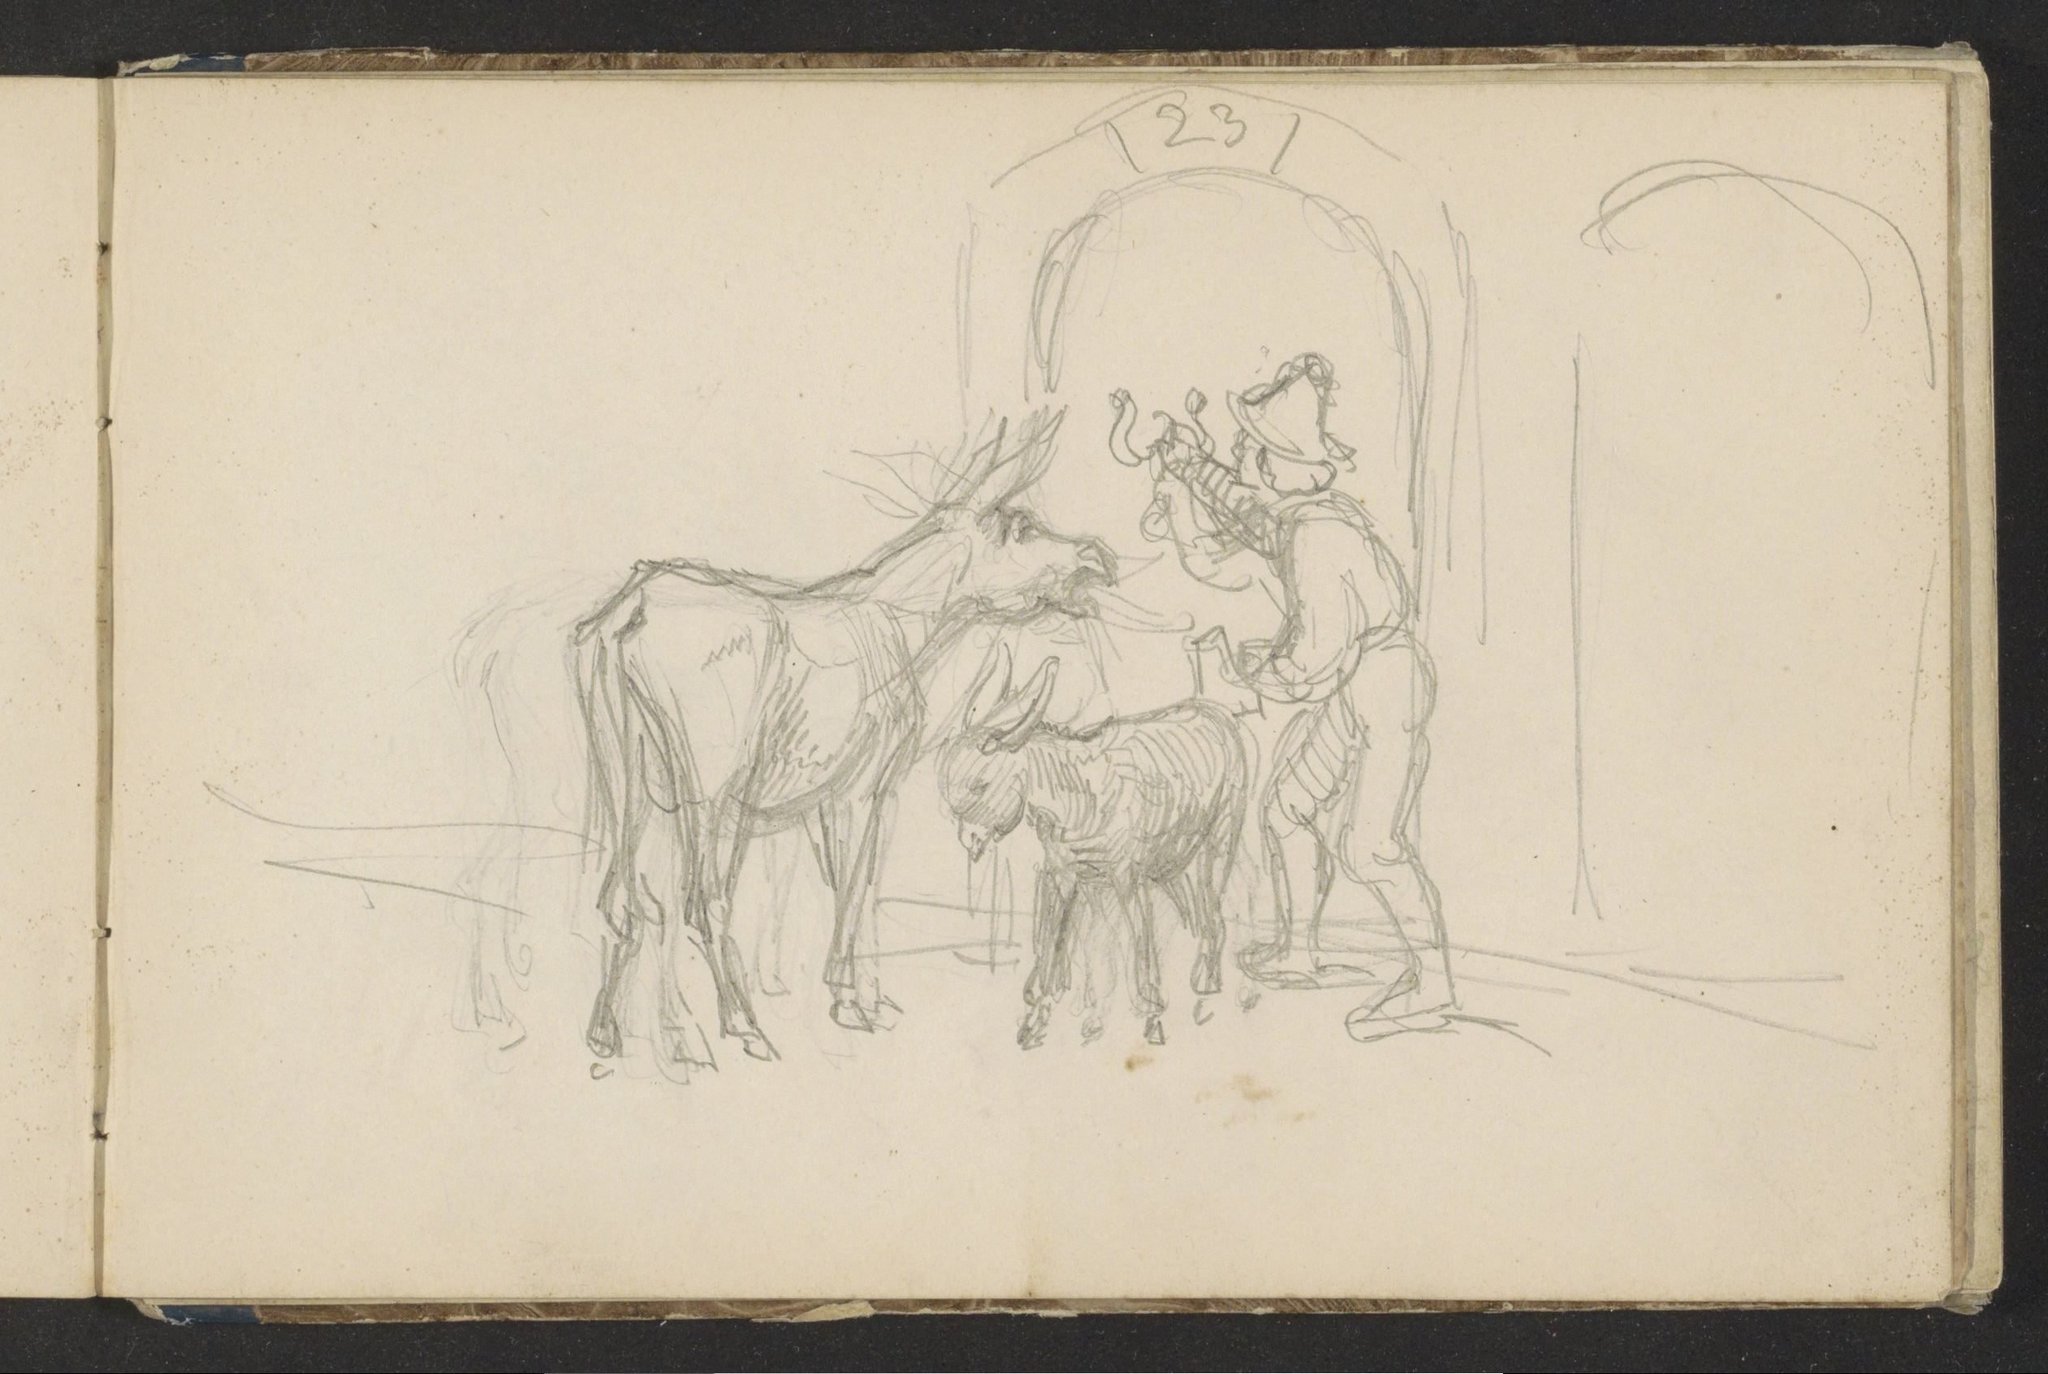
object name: sketchbook leaf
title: Man en twee ezels bij een poort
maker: Anonymous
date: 1841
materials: paper, pencil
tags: ass, donkey, gate, entrance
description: Blad 19 recto uit een schetsboek met 33 bladen.